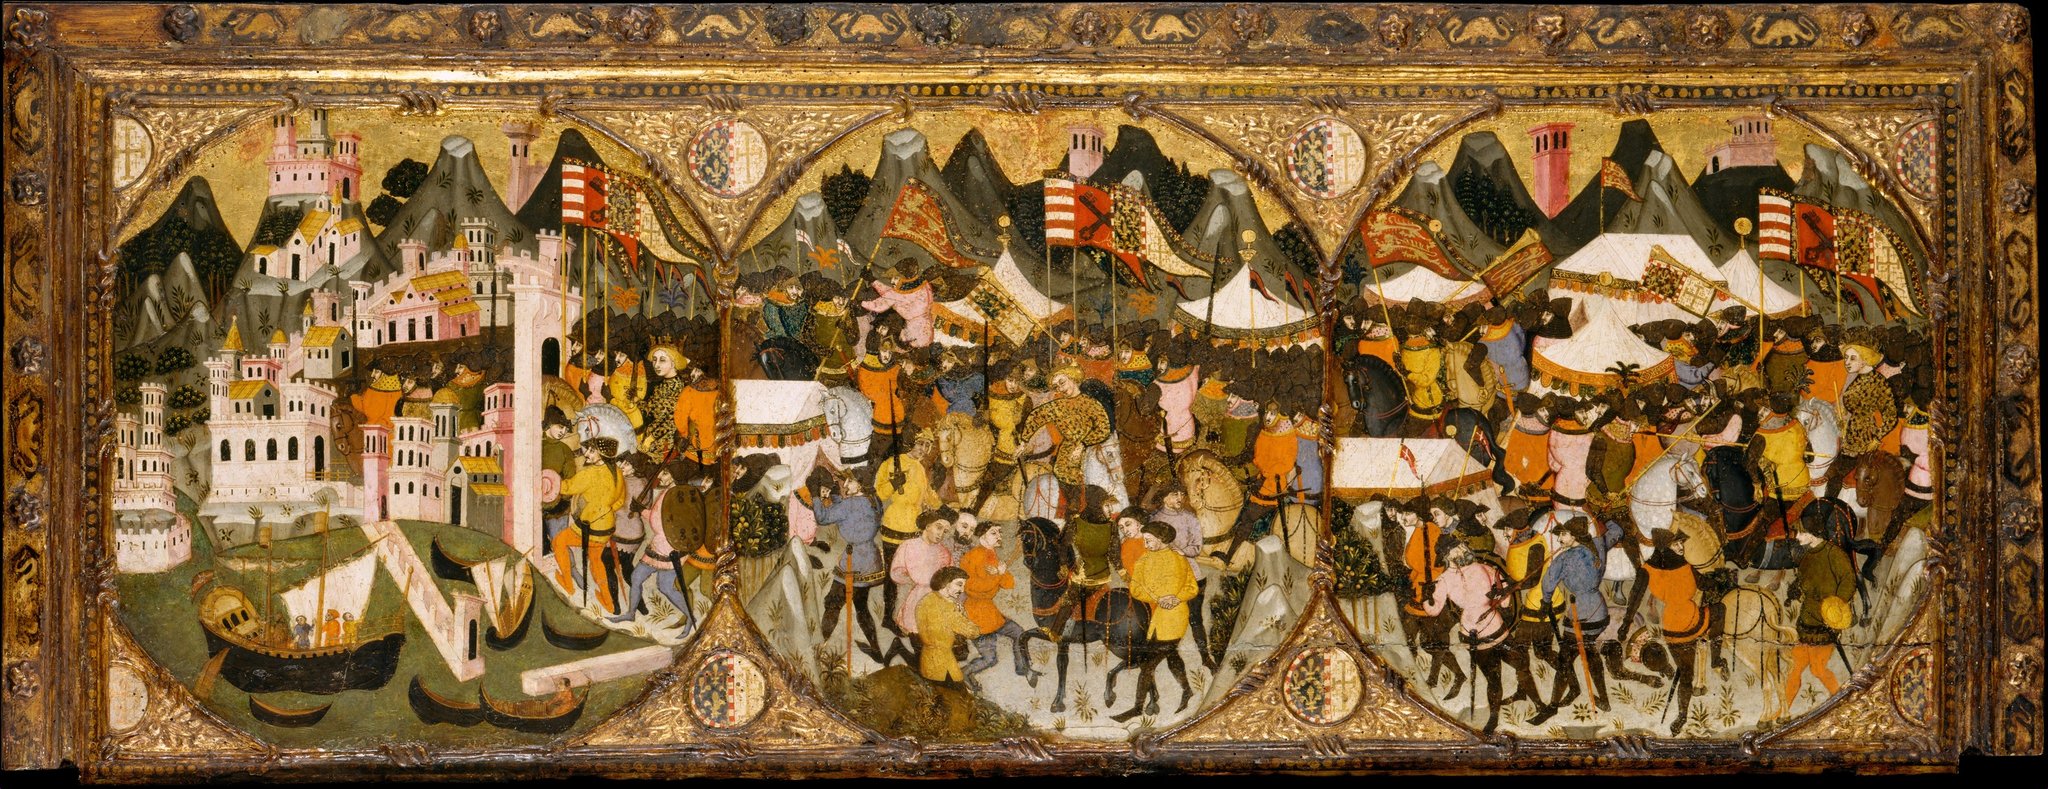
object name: painting, cassone panel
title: The Conquest of Naples by Charles of Durazzo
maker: master of charles of durazzo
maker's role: artist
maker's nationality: italian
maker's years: 1370-1399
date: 1381-1382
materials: gilt, paint, wood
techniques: embossing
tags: battles,army,kings,men,horses,flags